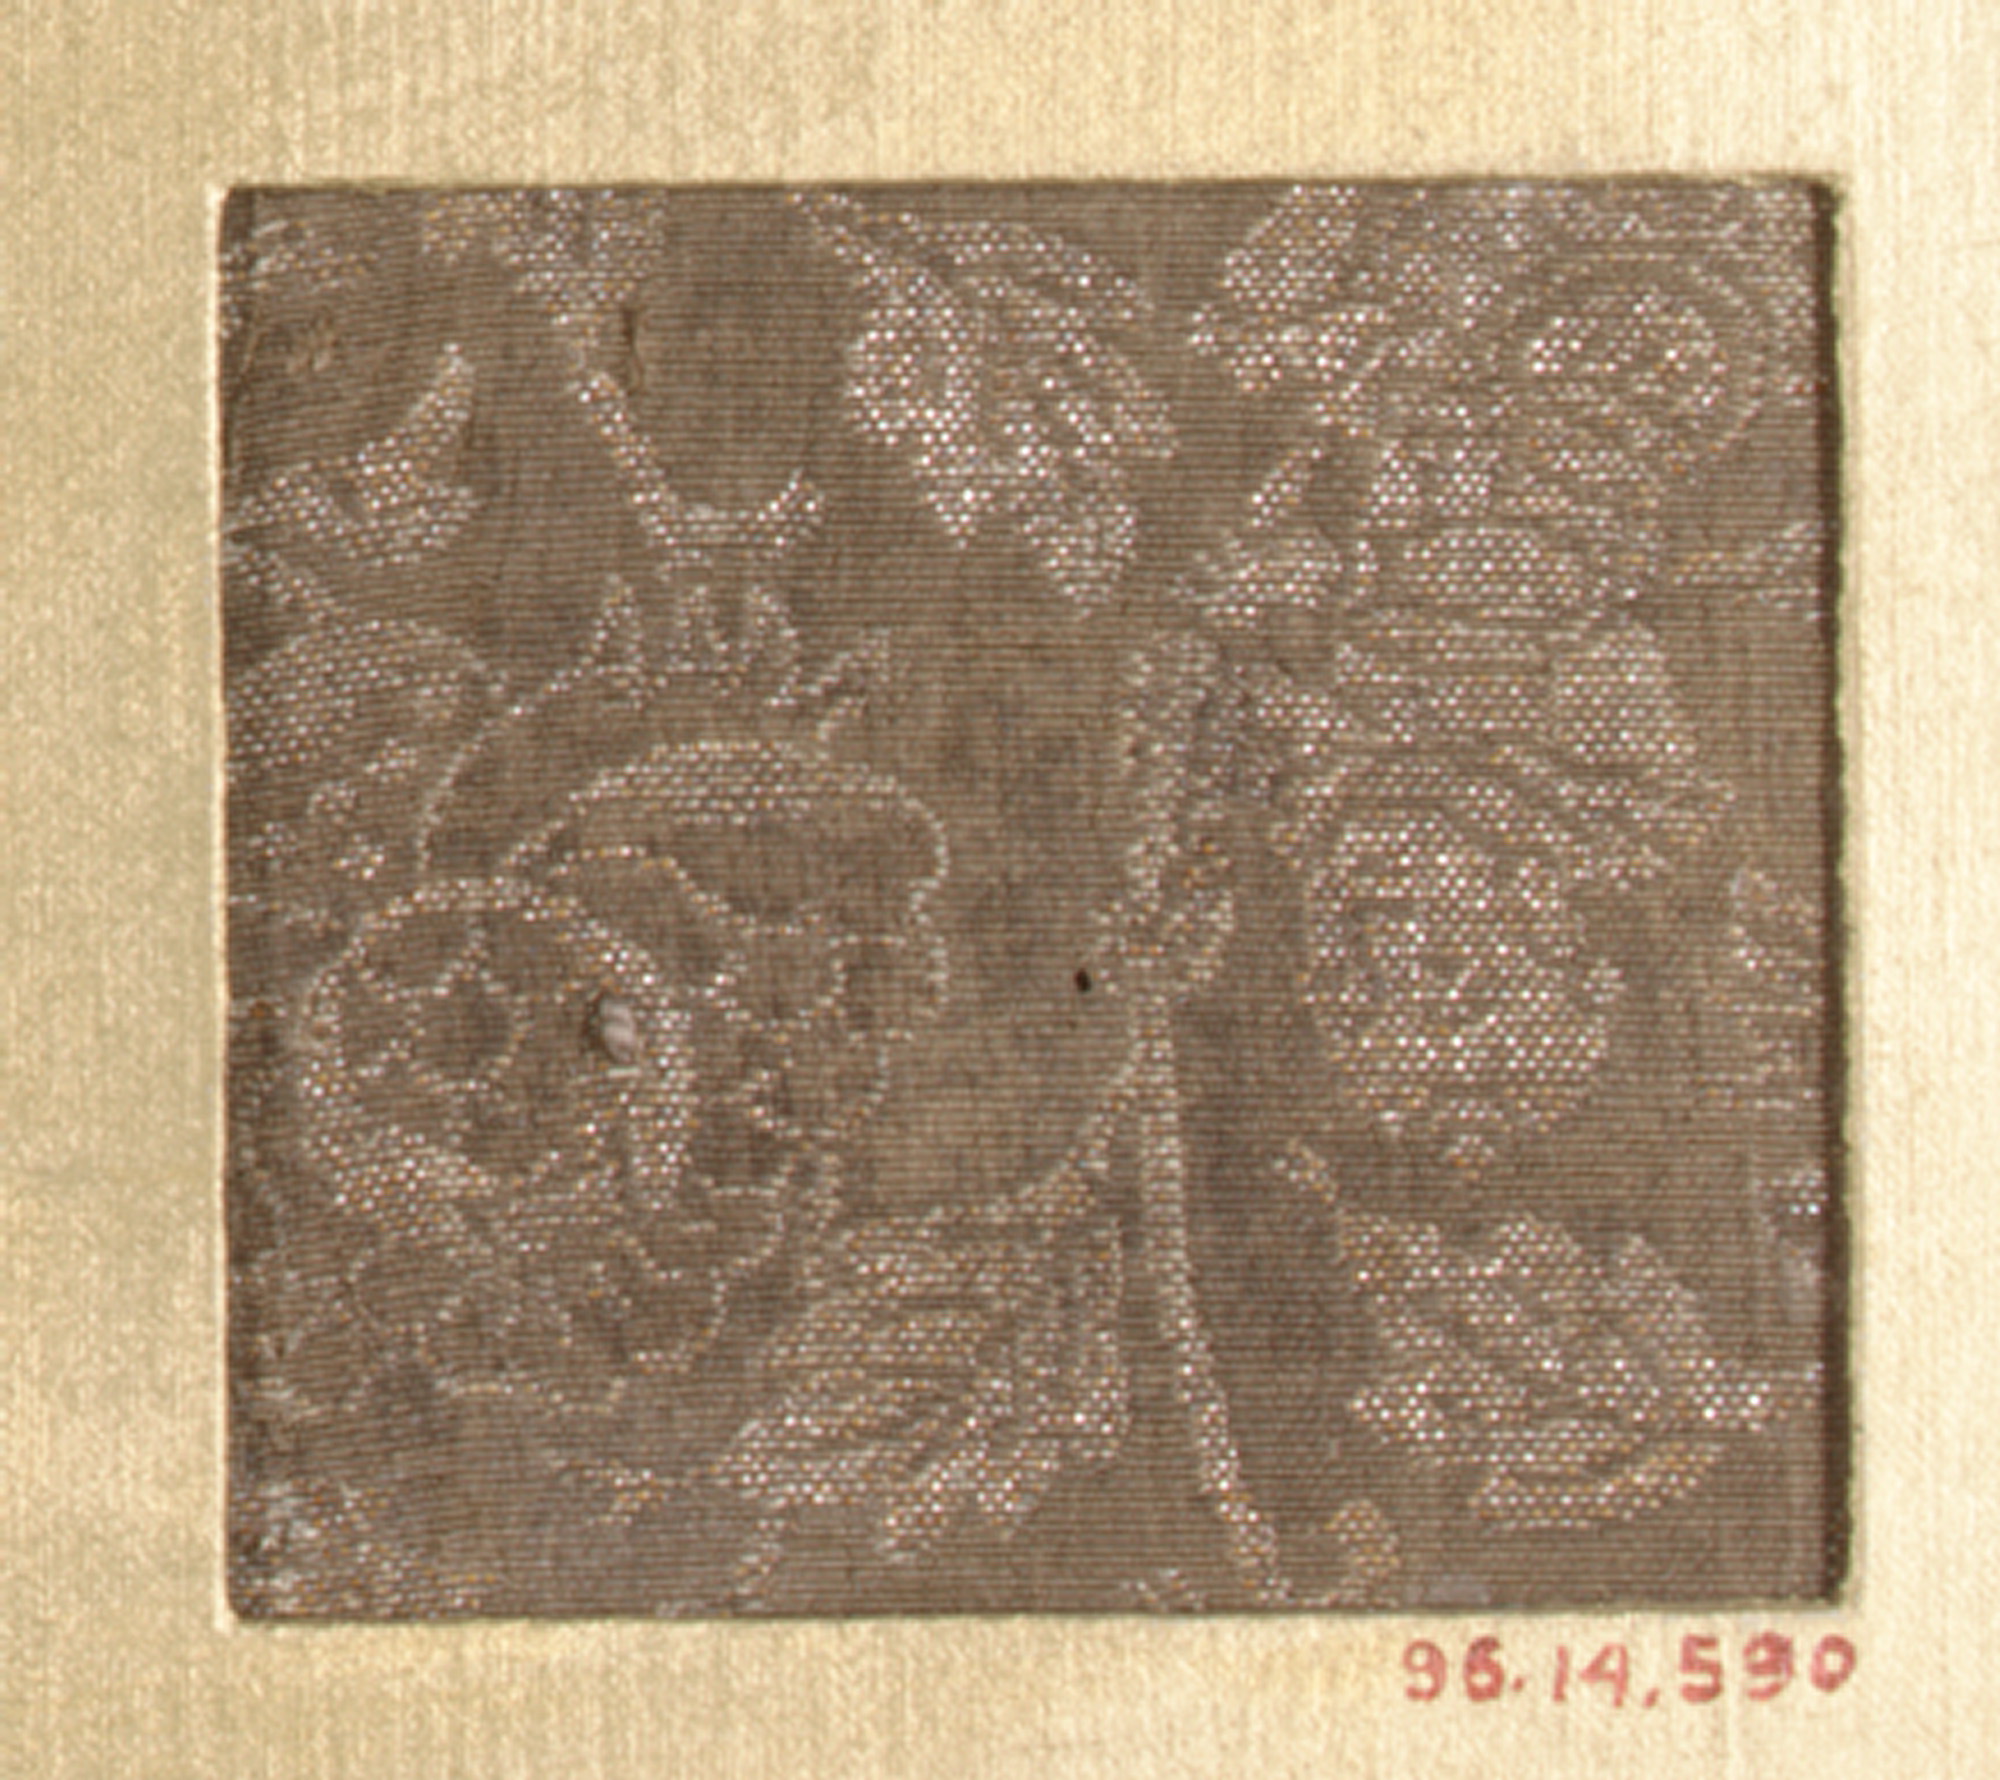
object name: piece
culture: japanese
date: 1701-1900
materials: silk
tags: flowers